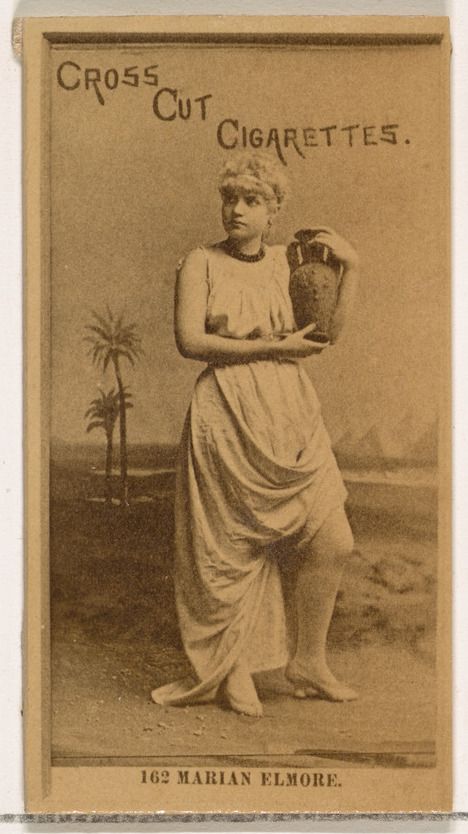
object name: print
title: Card Number 162, Marian Elmore, from the Actors and Actresses series (N145-2) issued by Duke Sons & Co. to promote Cross Cut Cigarettes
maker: w. duke, sons & co.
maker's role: publisher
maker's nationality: american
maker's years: 1870-1920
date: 1880-1889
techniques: albumen silver print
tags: portraits,women,actresses